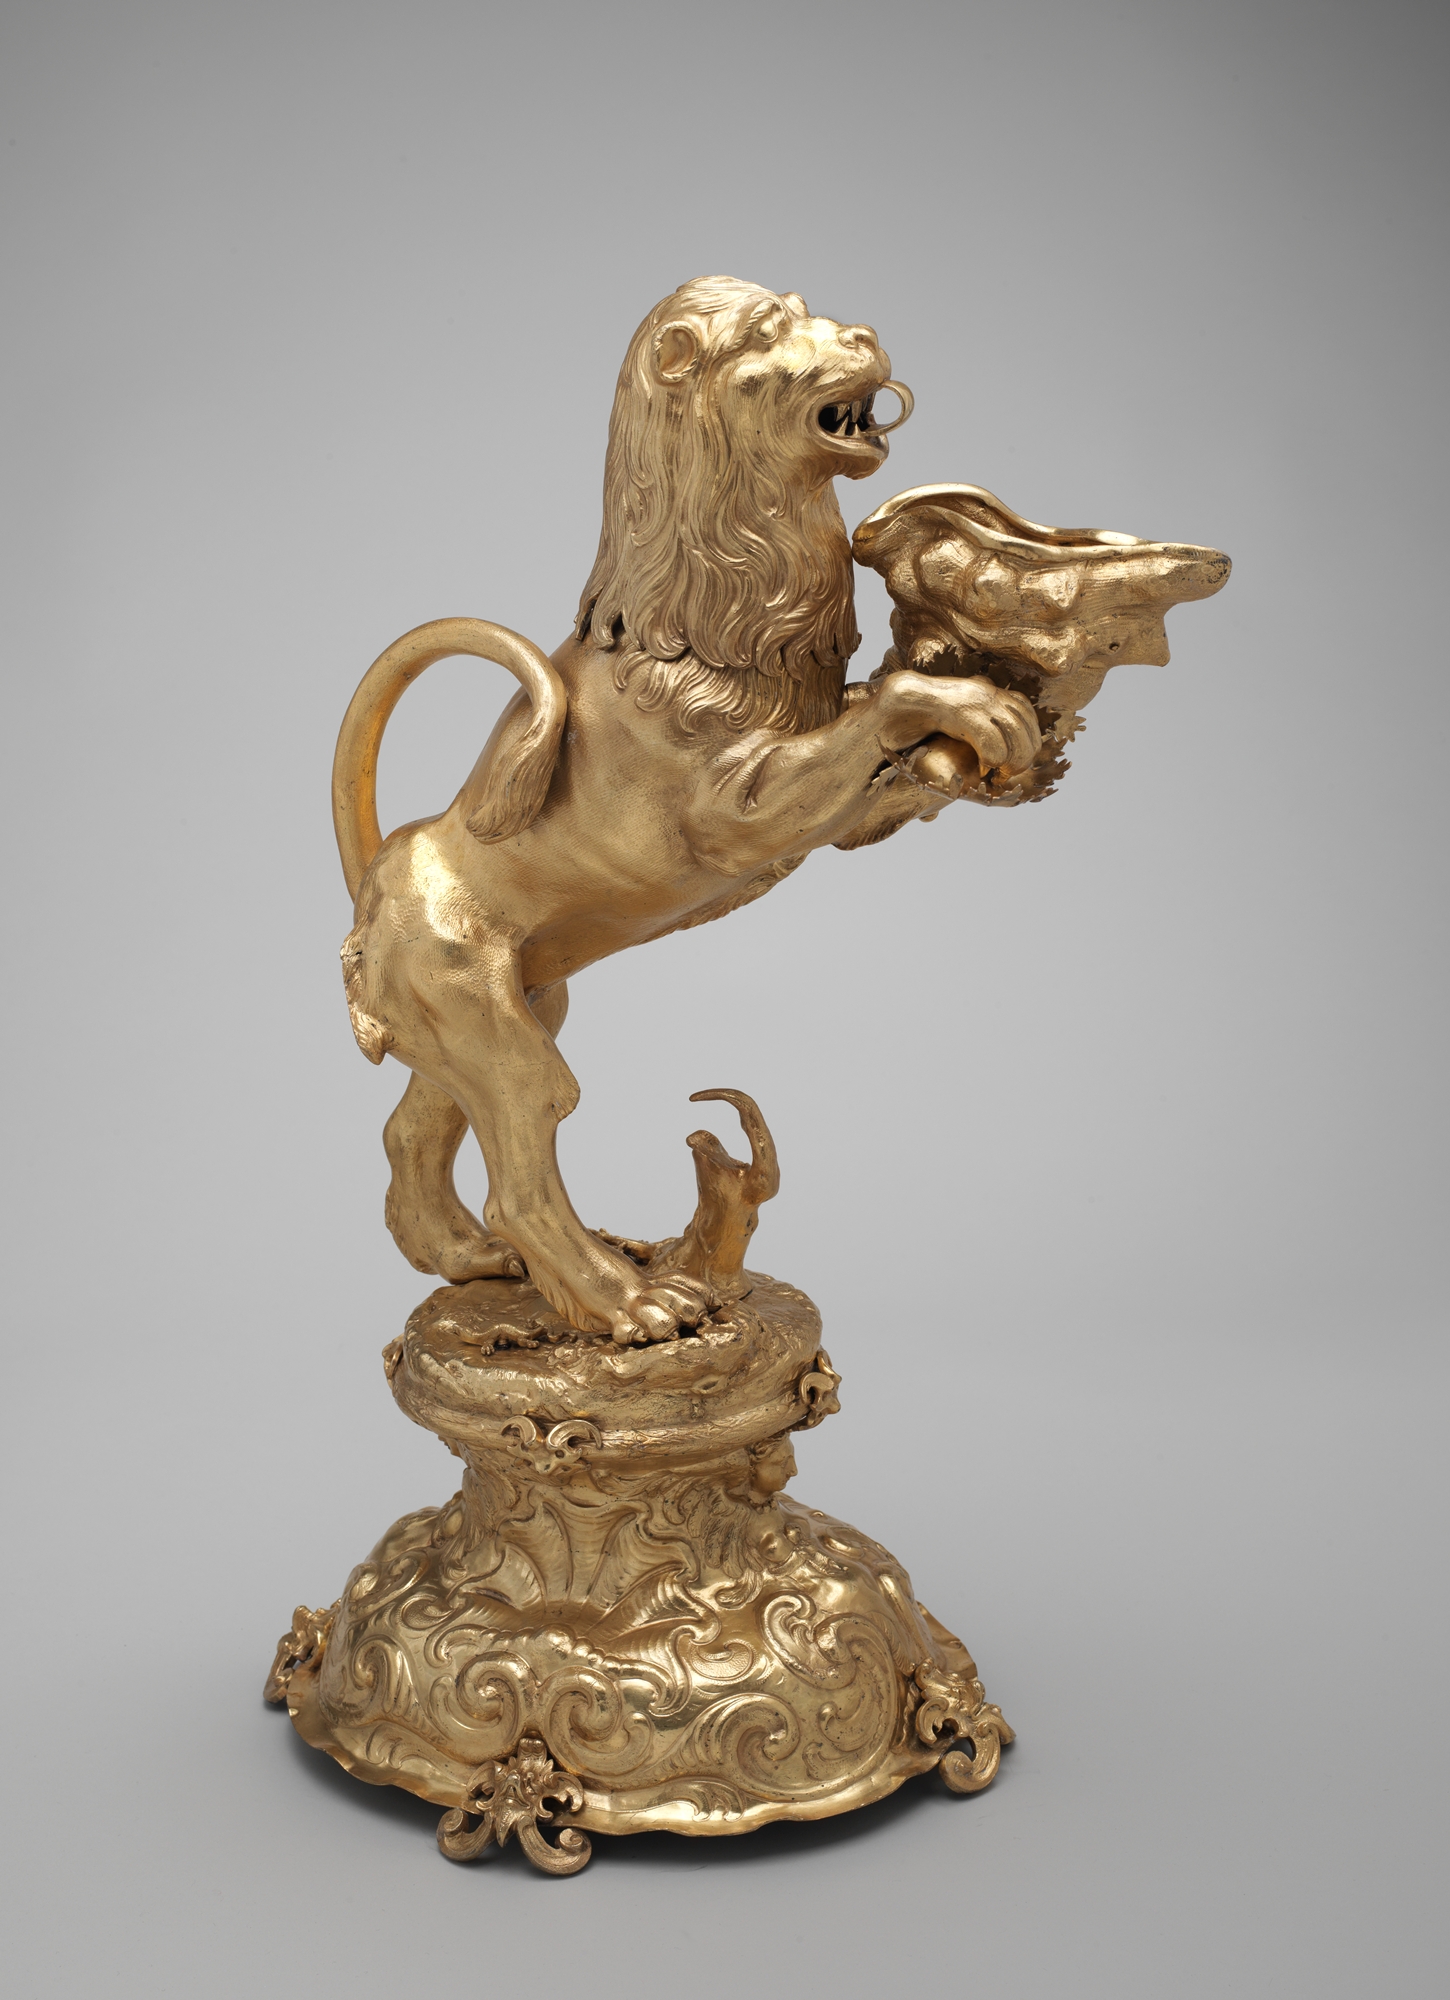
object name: cup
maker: elkington & co.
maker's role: manufacturer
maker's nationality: british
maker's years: 1829-1963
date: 1801-1900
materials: gilt, metal, silver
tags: lions